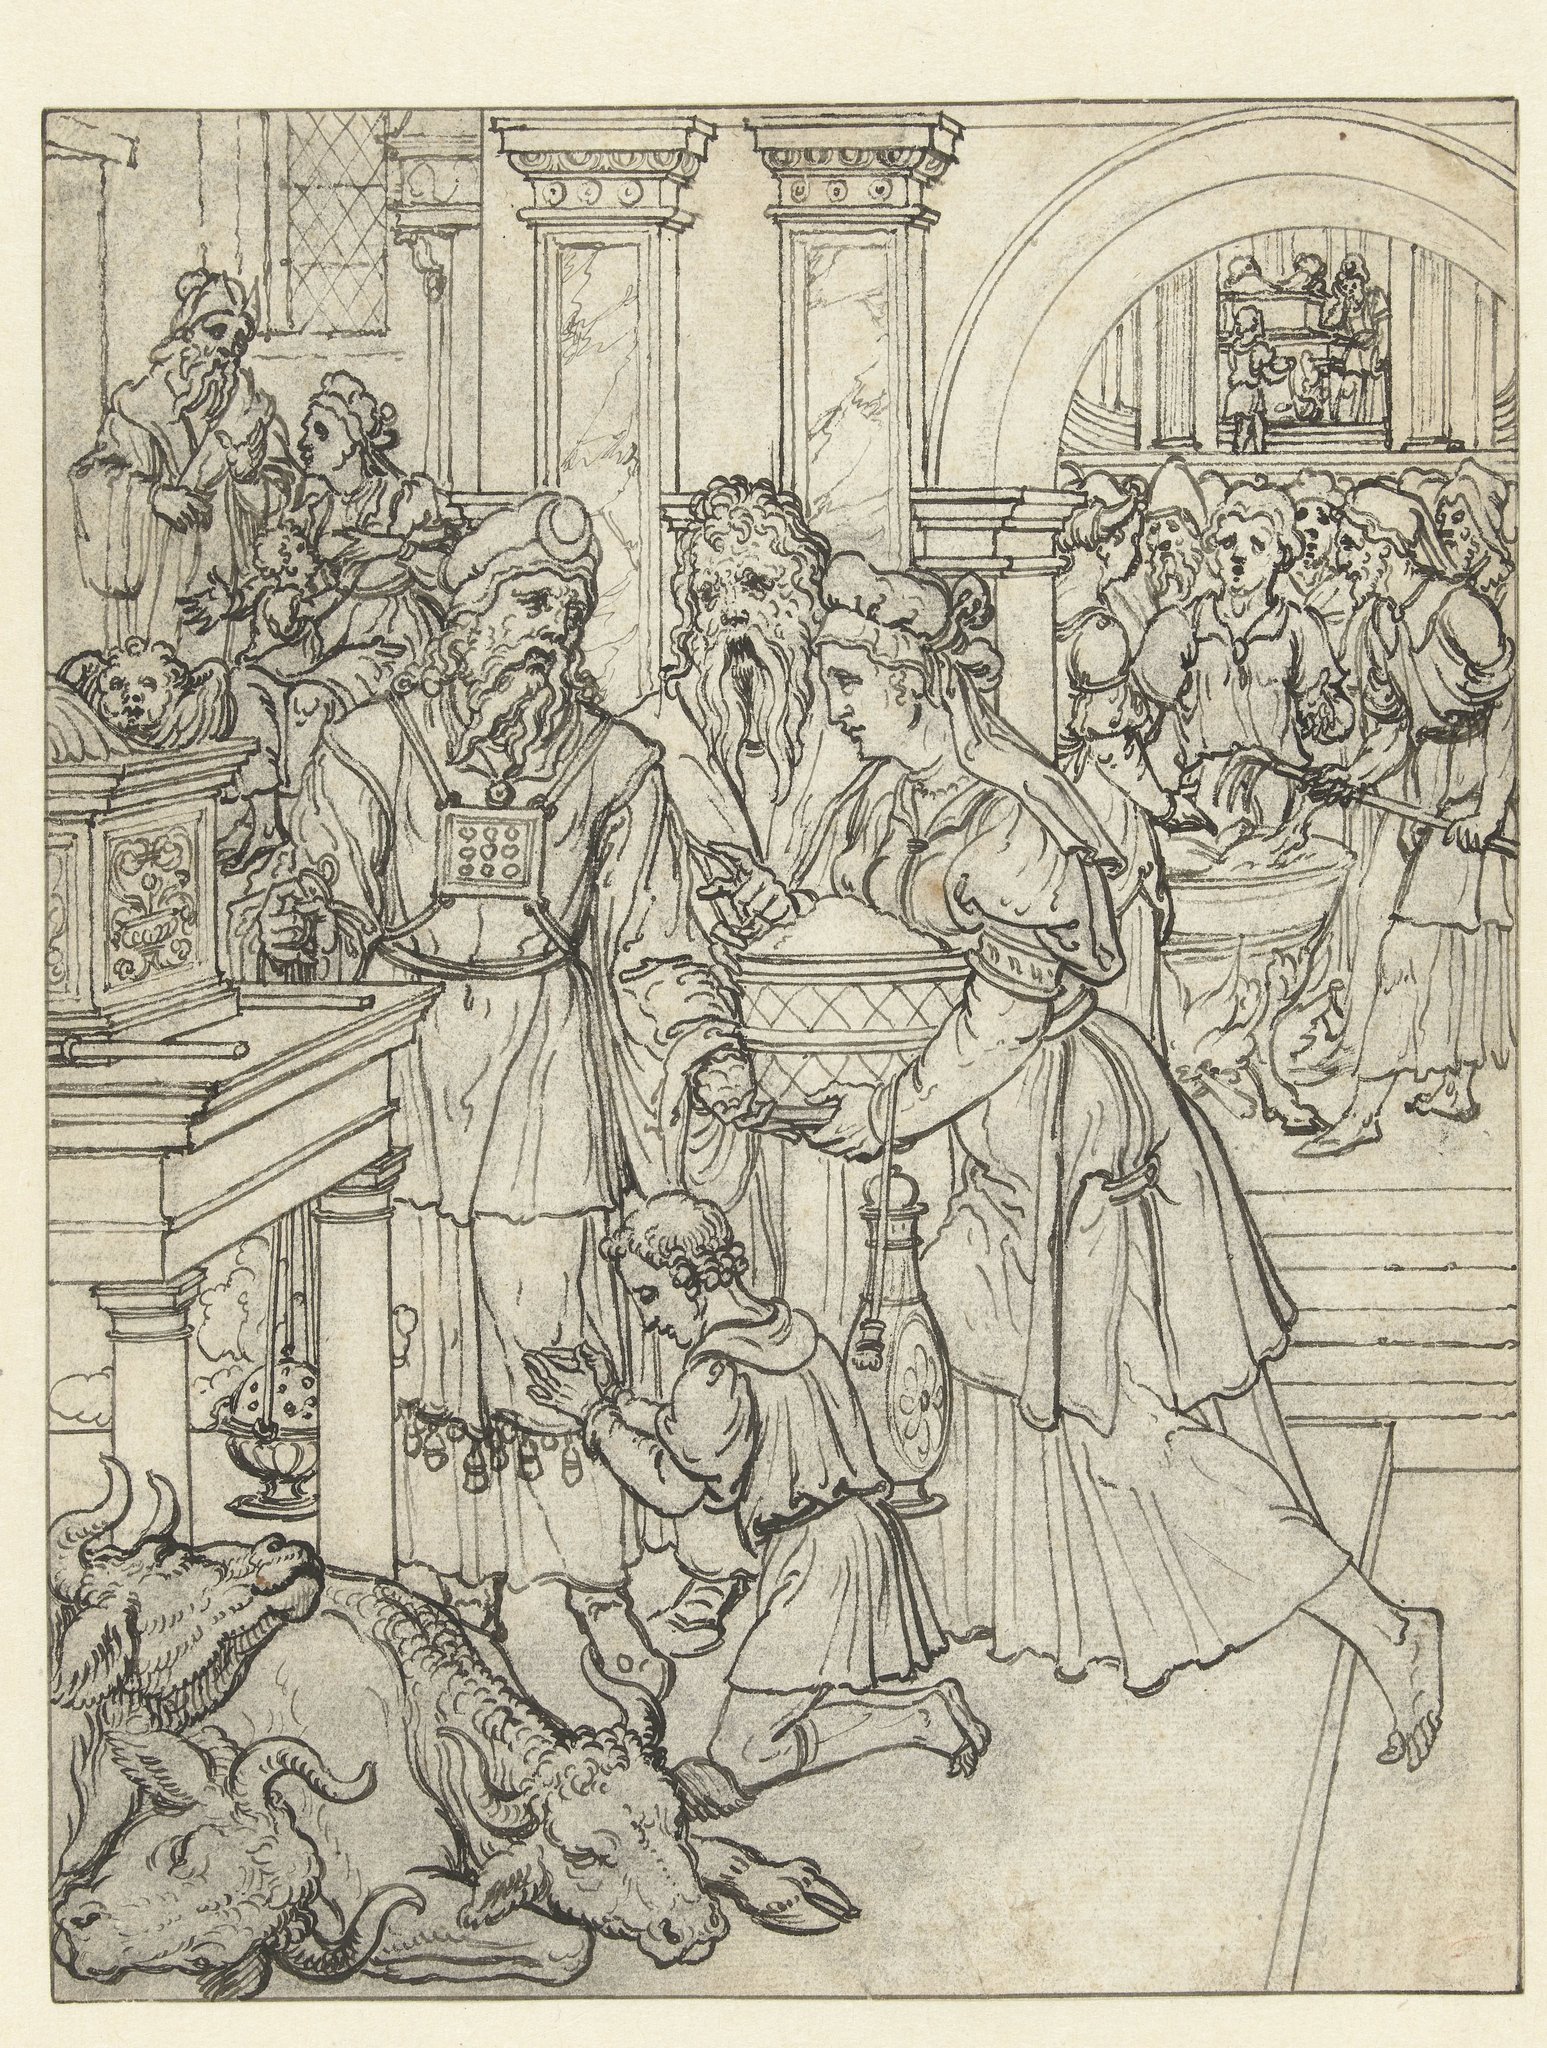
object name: design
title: Samuel en zijn ouders voor de hogepriester Eli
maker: dirck pietersz. crabeth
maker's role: draughtsman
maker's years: 1520-1574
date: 1540-1543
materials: chalk, ink, paper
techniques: pen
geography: leiden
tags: birth and childhood of samuel (1 samuel 1-2:21)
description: Ontwerp voor een glasruit in het huis "Pax huic domui" in Leiden, 1543, met een voorstelling van Samuel en zijn ouders voor de hogepriester Eli (1 Sam. 1; vers 25-28).